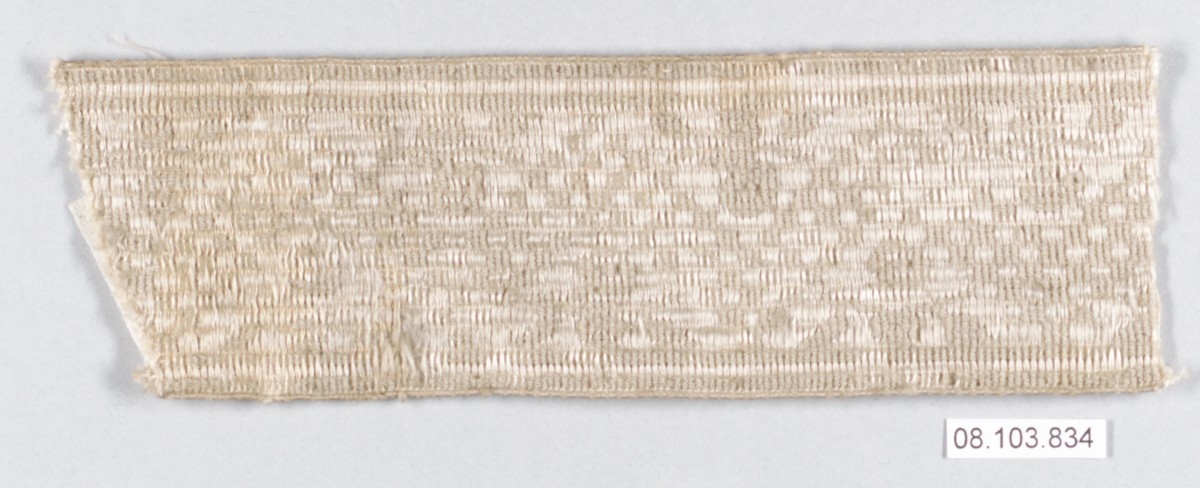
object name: galloon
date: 1601-1700